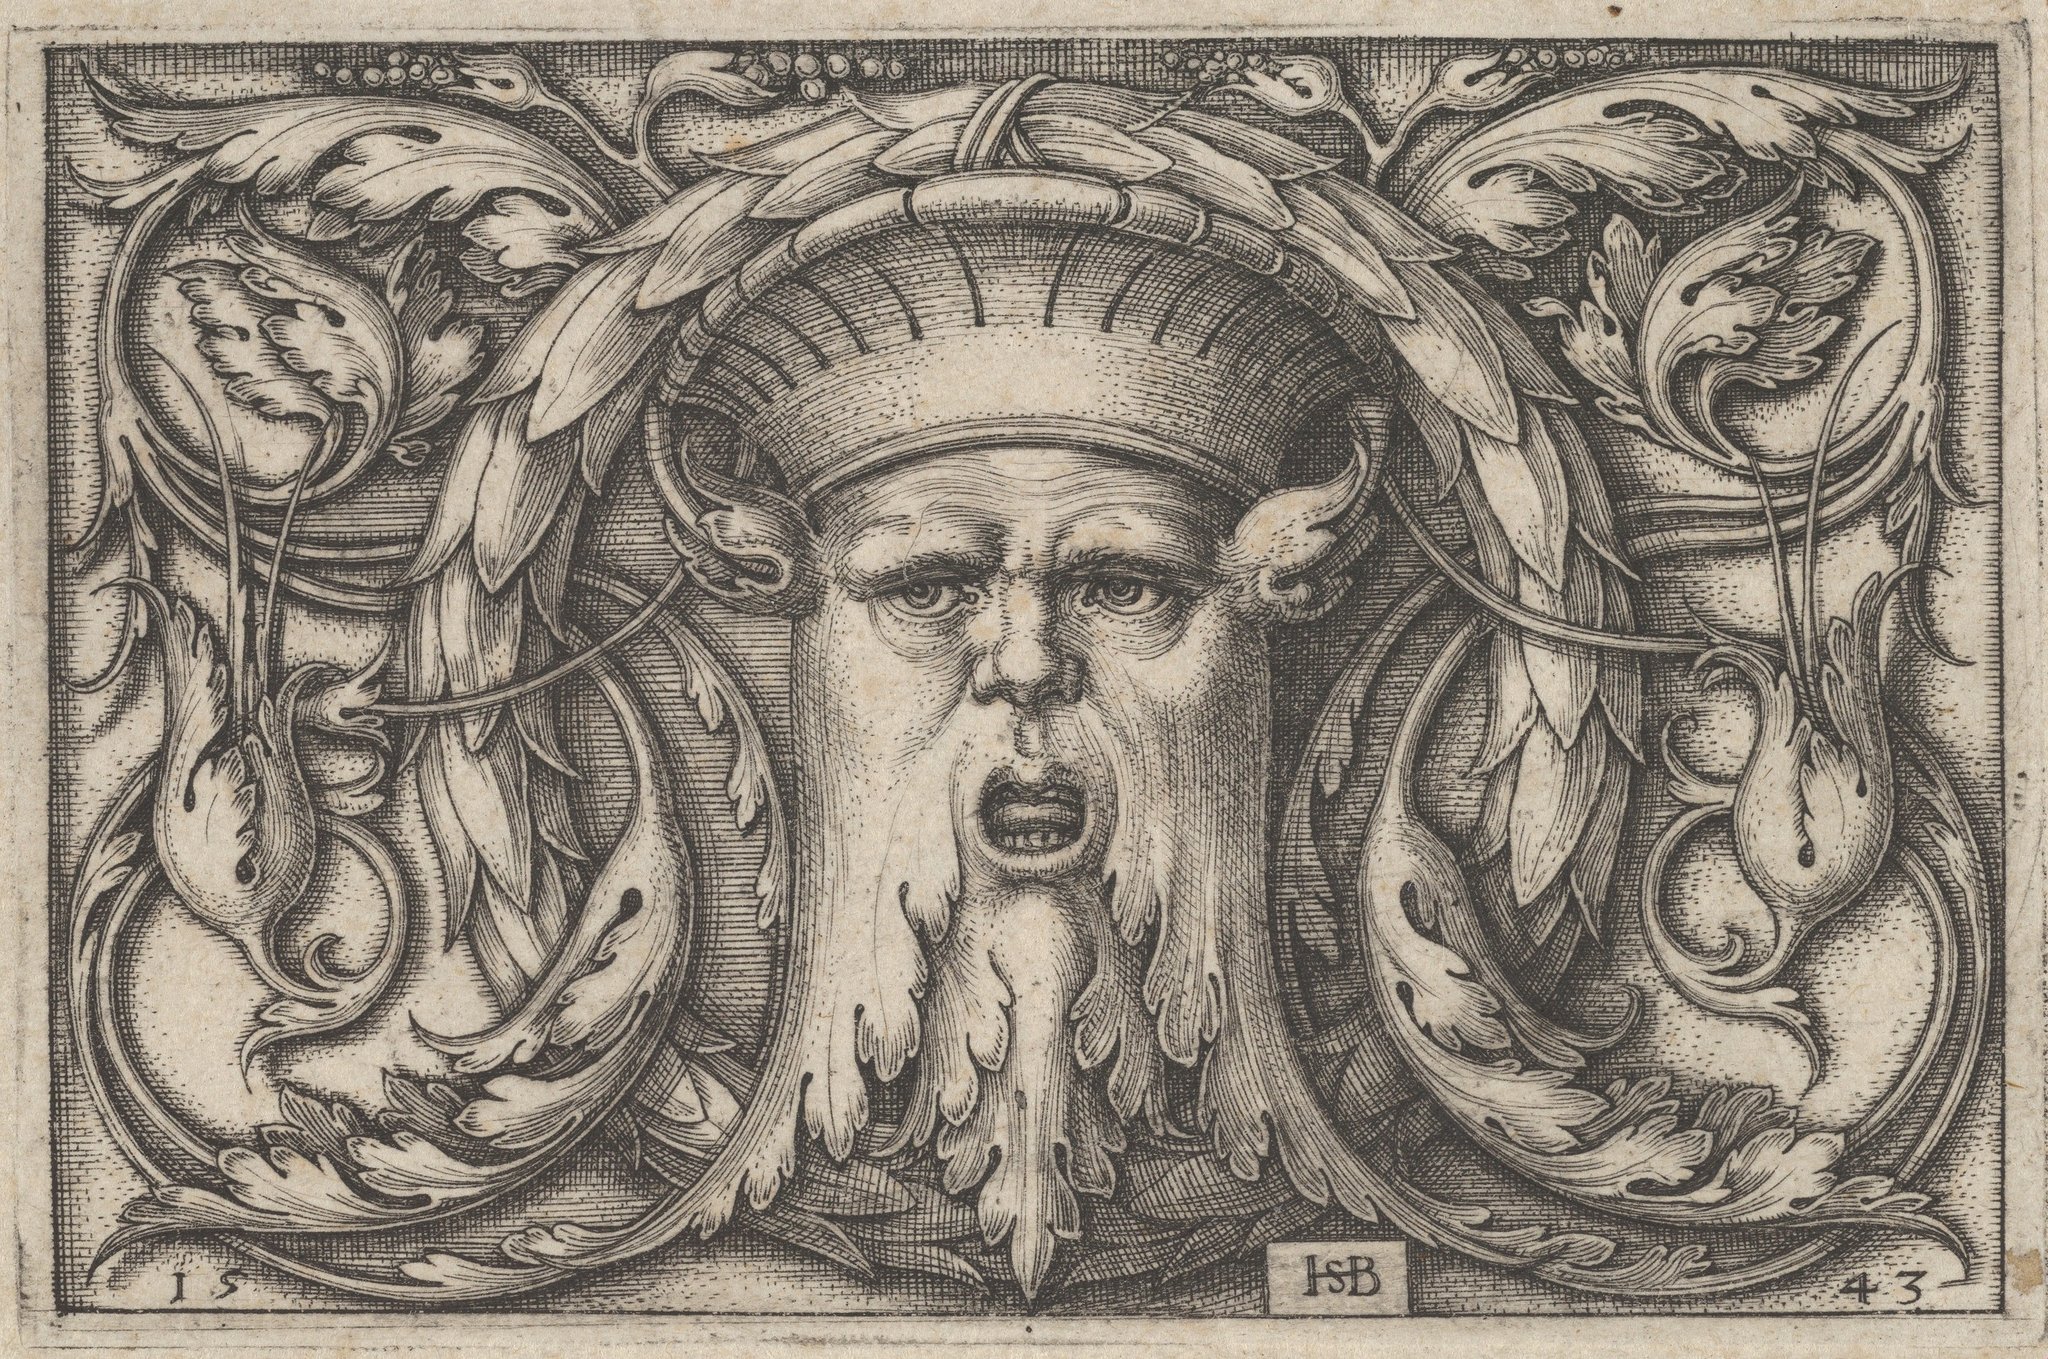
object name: print ornament architecture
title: Horizontal Panel with a Bearded Amascaron in a Medallion at Center Surrounded by Tendrils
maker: sebald beham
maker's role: artist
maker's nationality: german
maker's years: 1500-1550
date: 1543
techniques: engraving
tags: masks